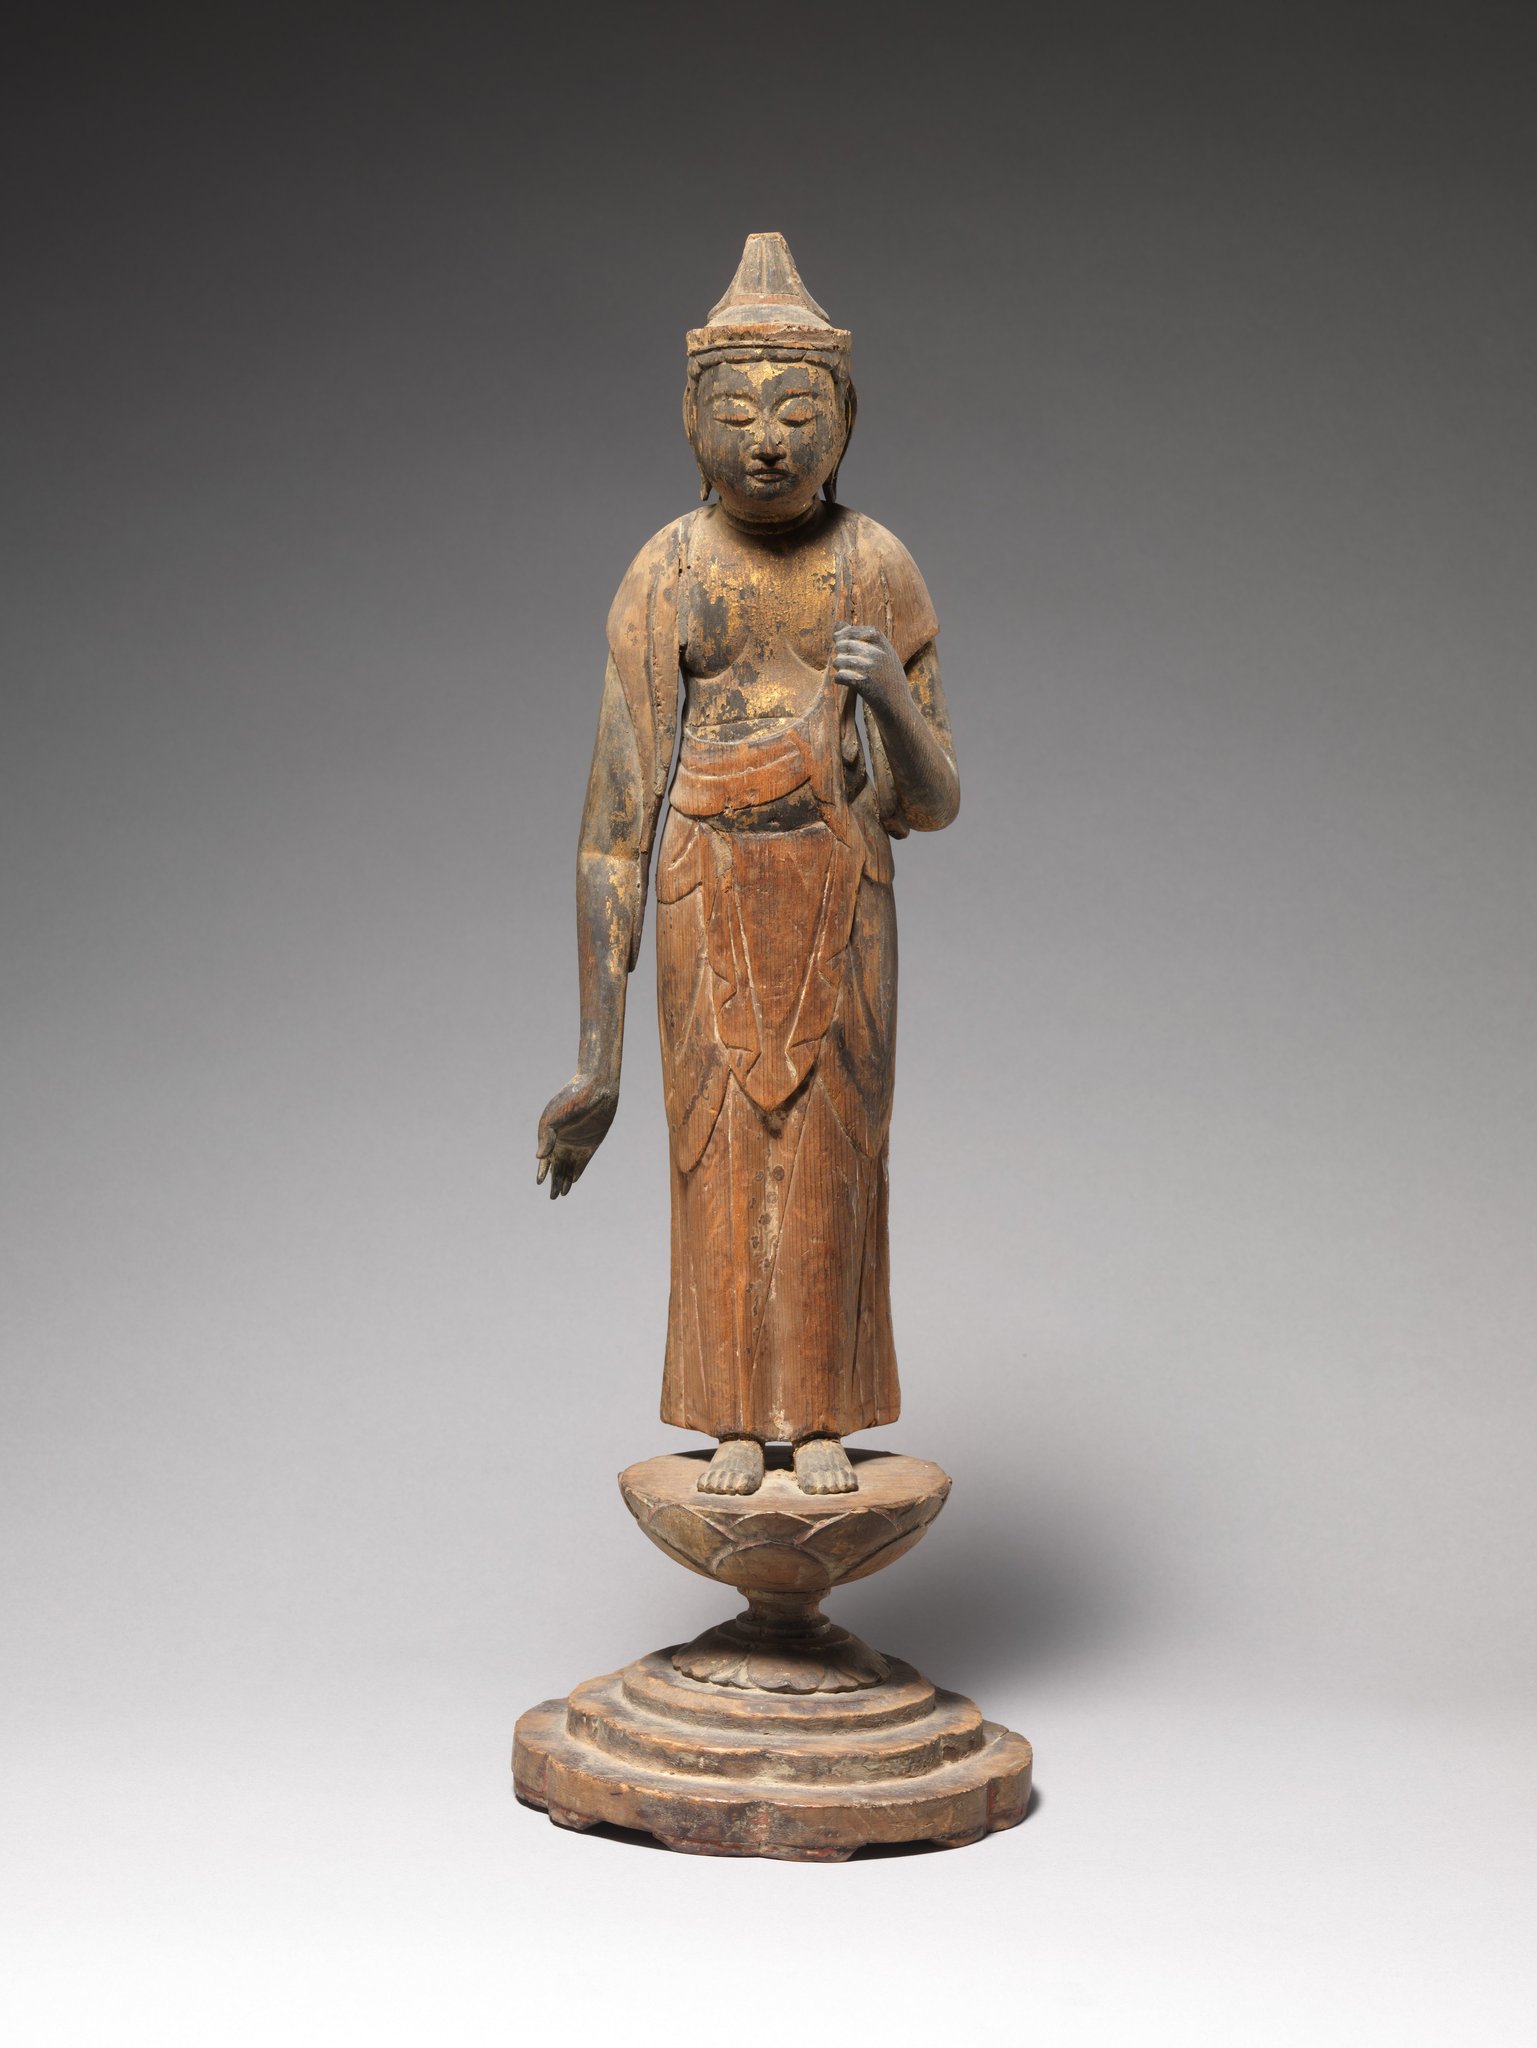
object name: figure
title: Shō Kannon, the Bodhisattva of Compassion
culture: japanese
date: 1101-1200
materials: gold, wood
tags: buddhism,avalokiteshvara,bodhisattvas